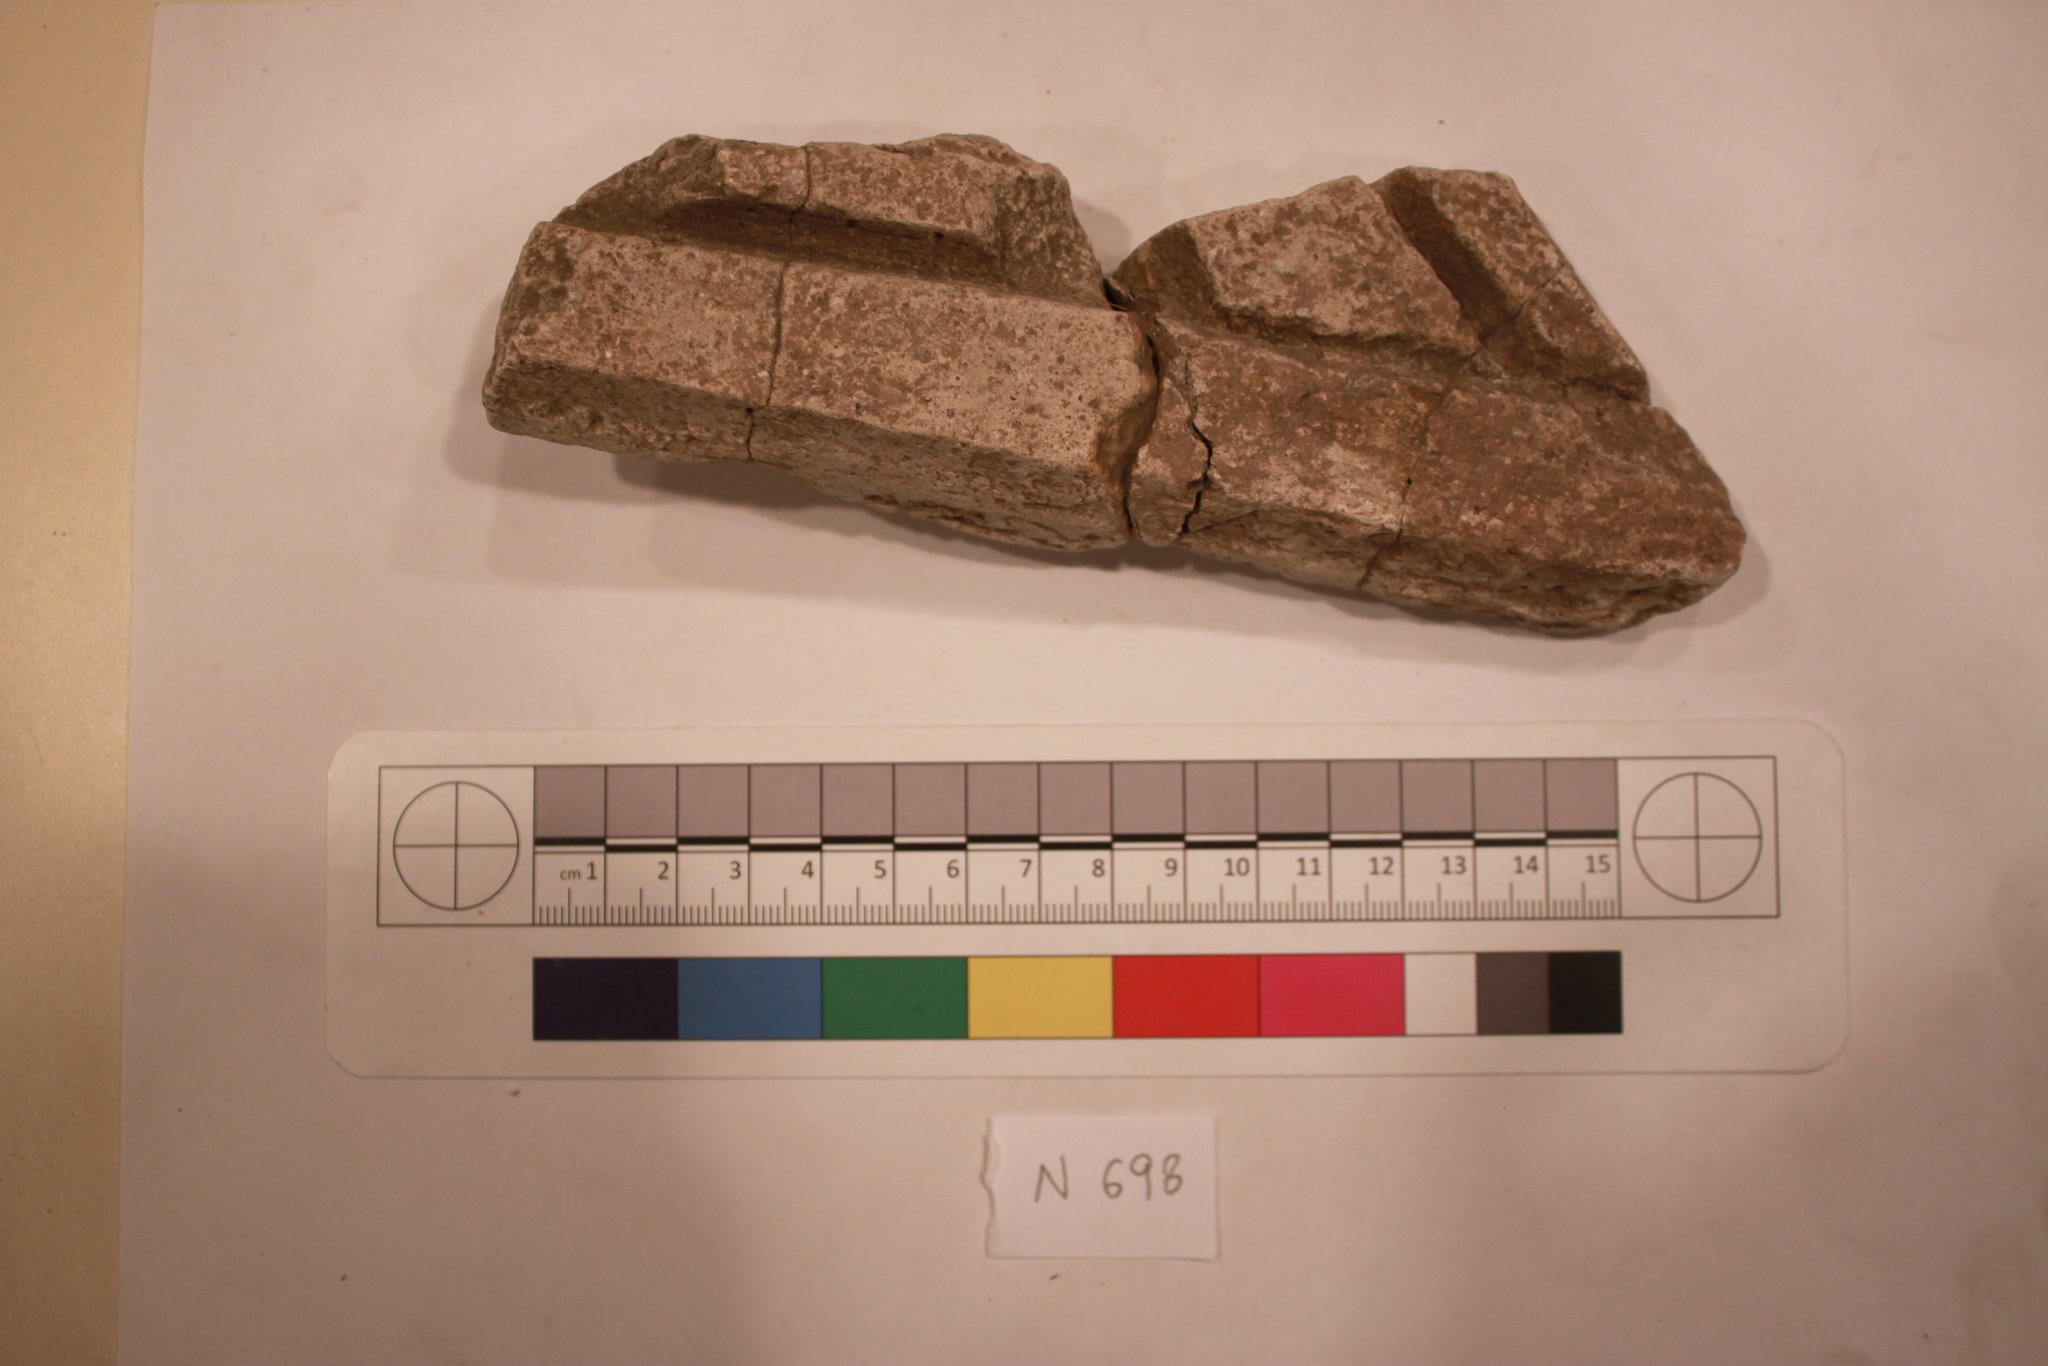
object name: fragment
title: Stucco Fragment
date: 701-1200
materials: plaster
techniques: carving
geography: iran